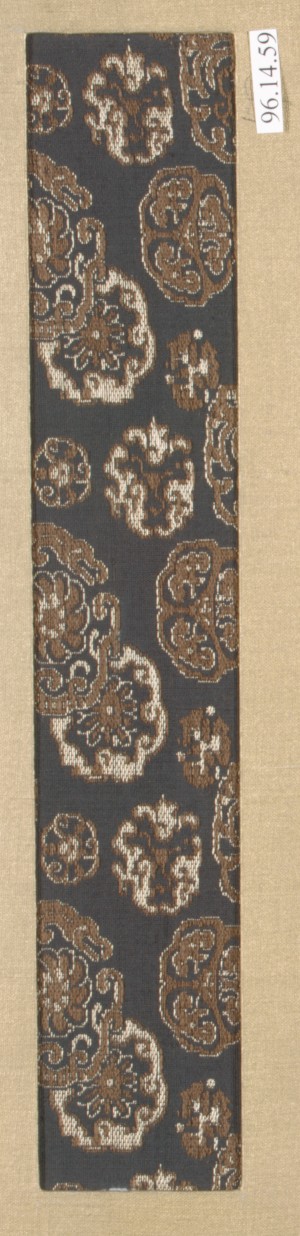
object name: piece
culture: japanese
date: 1701-1800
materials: silk